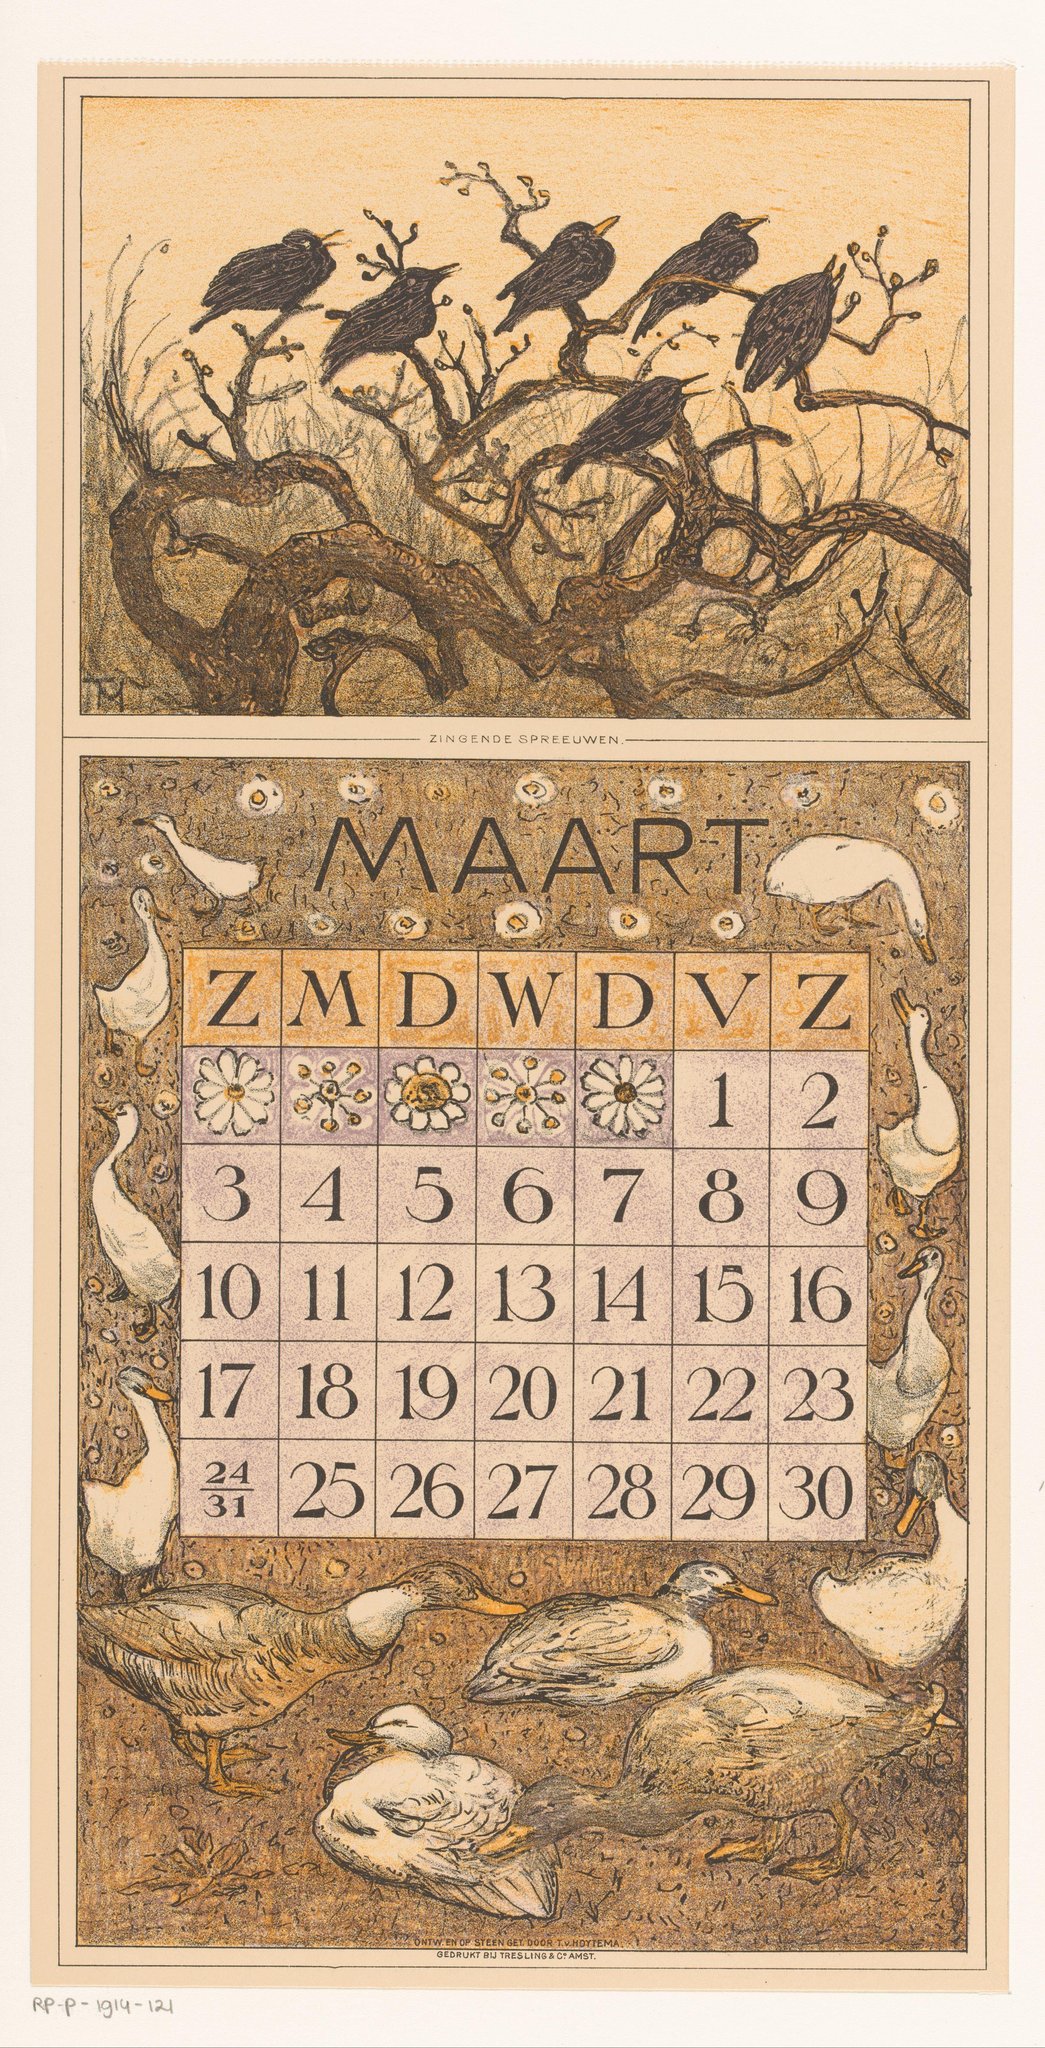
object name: print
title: Kalenderblad maart met spreeuwen en eenden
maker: theo van hoytema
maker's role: draughtsman, painter, print maker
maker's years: 1863-1917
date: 1911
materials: paper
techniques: lithograph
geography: amsterdam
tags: song-birds: starling, water-birds: duck, march ~ other concepts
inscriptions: collector's mark: Lugt 2228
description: De spreeuwen zitten in een boom. In de ornamentrand eenden. Bovenaan het blad een scheurlijn.